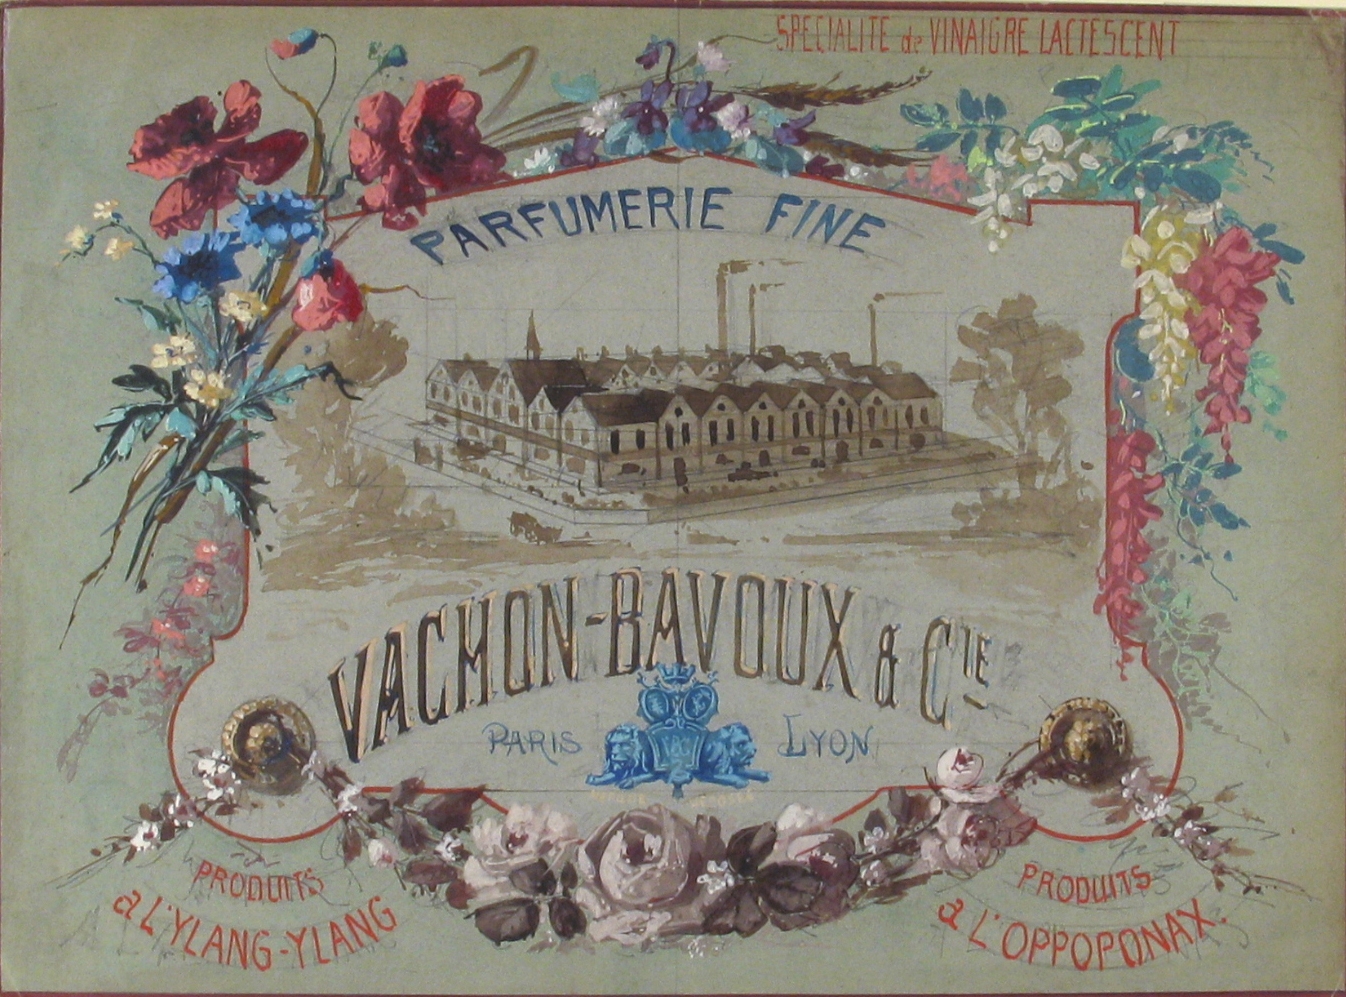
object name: drawing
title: Parfumerie Fine: Vachon-Bachoux et Cie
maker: anonymous, french, 19th century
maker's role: artist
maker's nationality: french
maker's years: 1800-1900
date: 1801-1900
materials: graphite, watercolor, paper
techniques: wash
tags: buildings,flowers